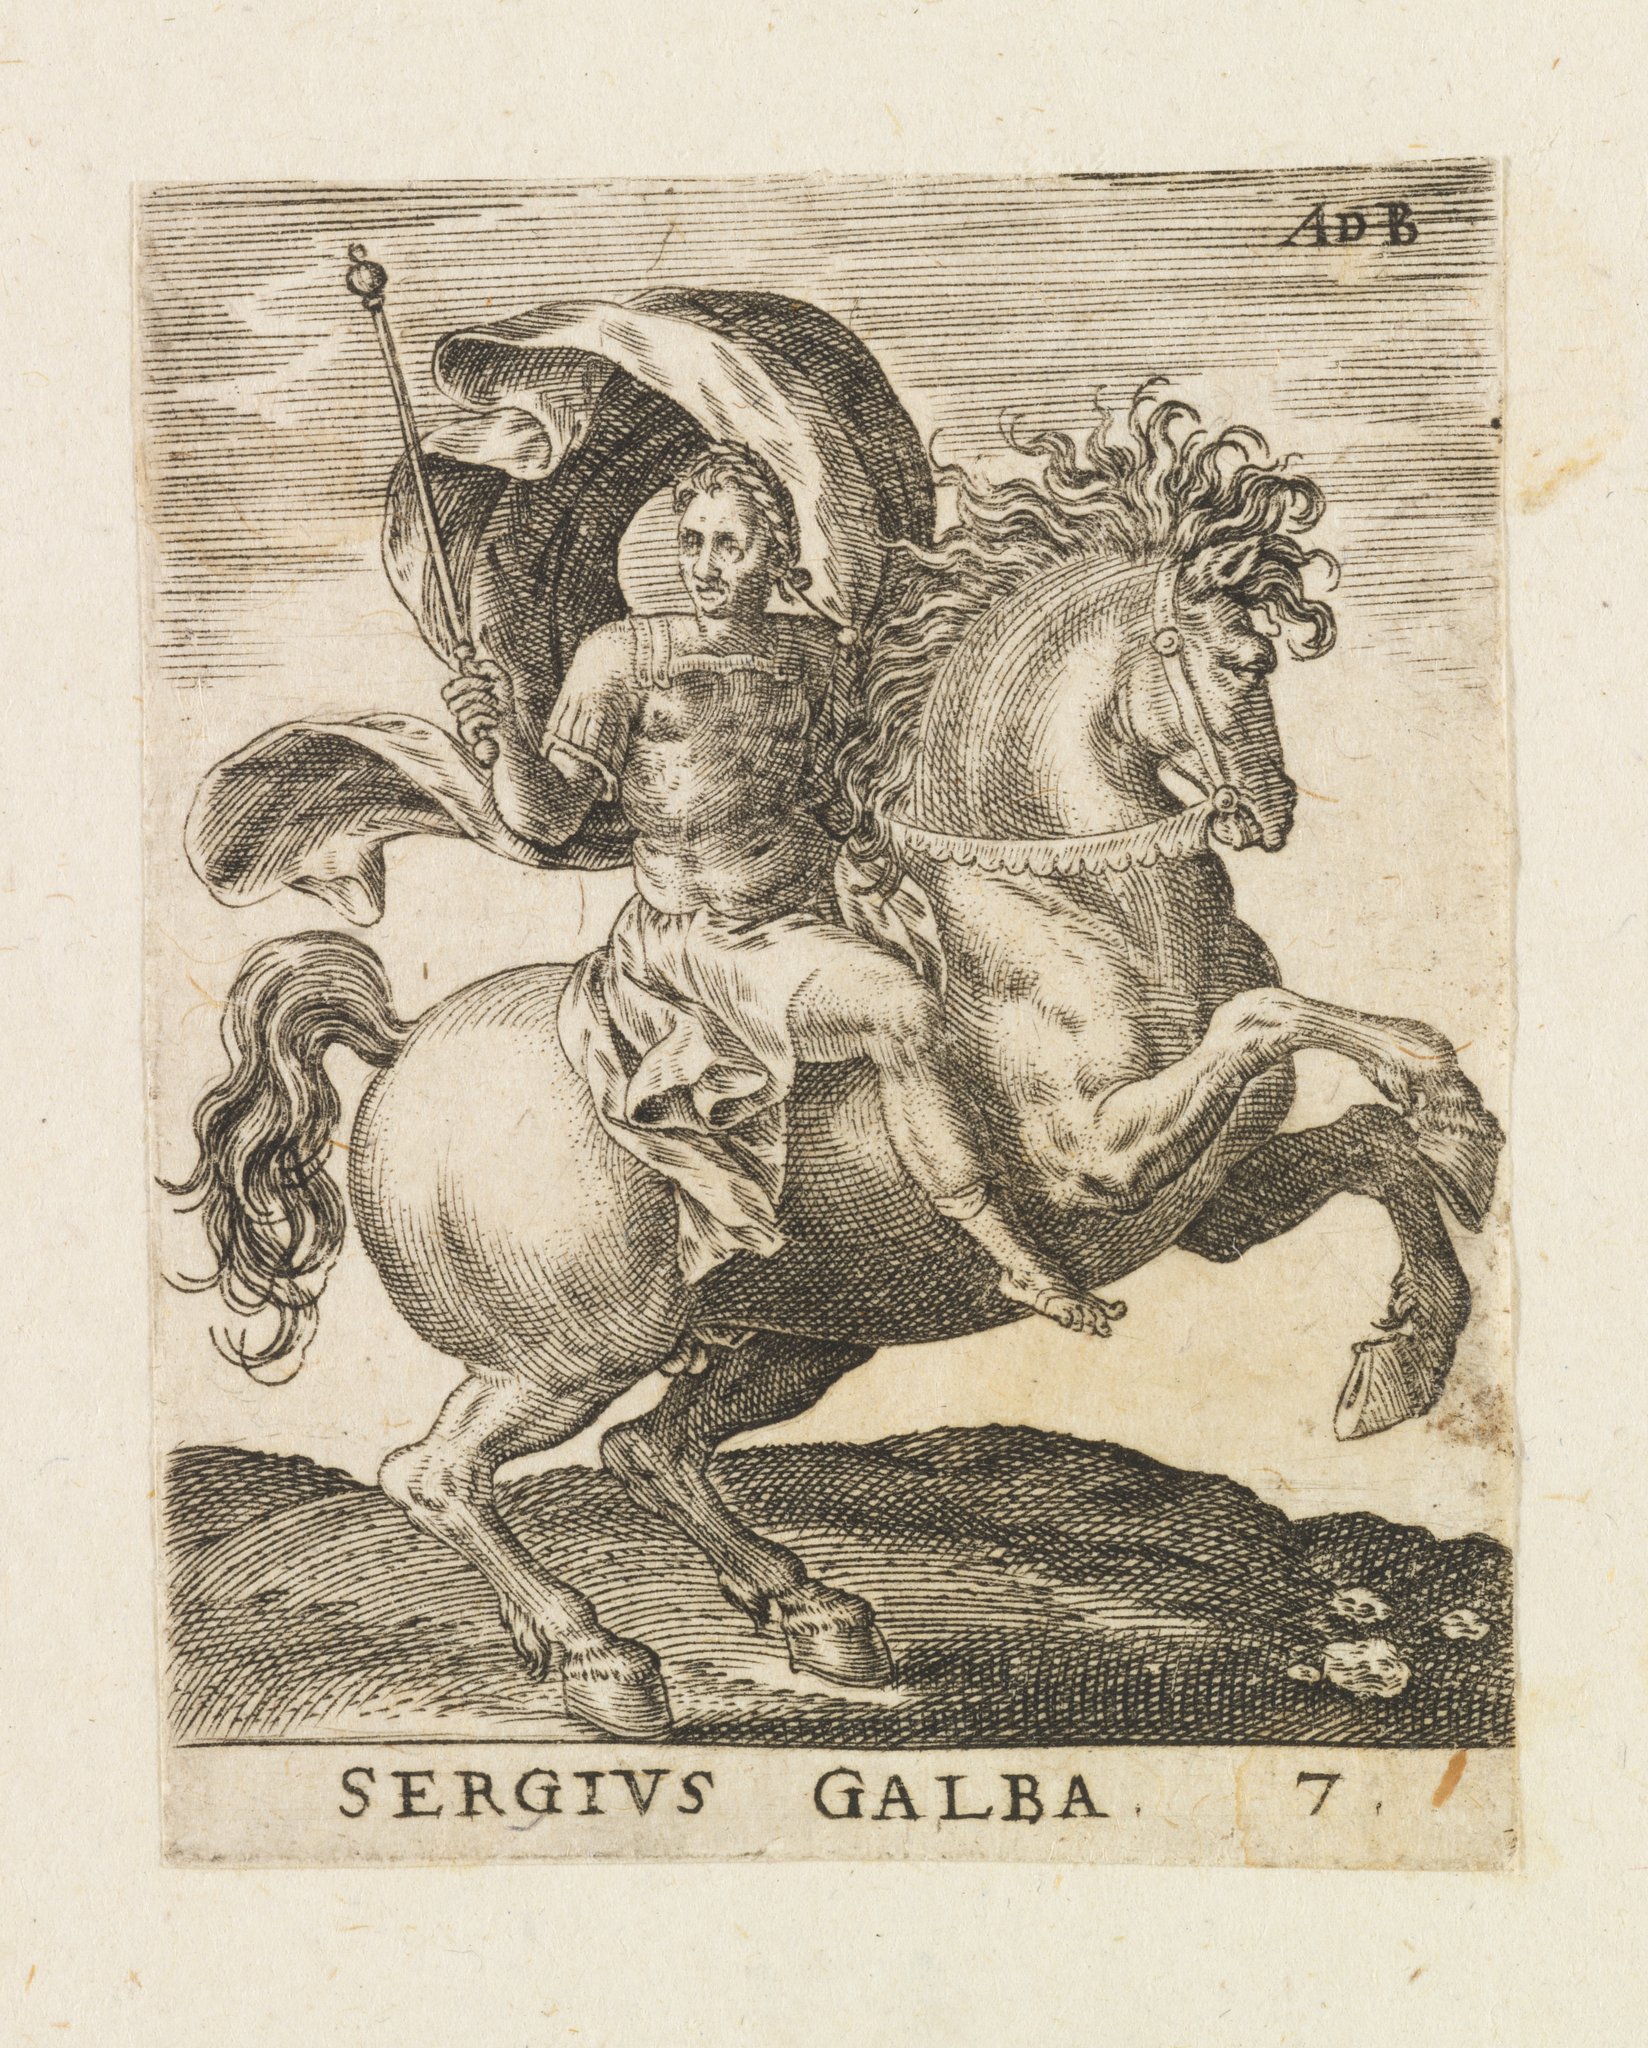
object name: print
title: Sergius Galba, from "Twelve Caesars on Horseback"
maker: abraham de bruyn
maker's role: artist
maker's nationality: flemish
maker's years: 1540-1587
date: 1565-1587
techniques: engraving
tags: men,horses